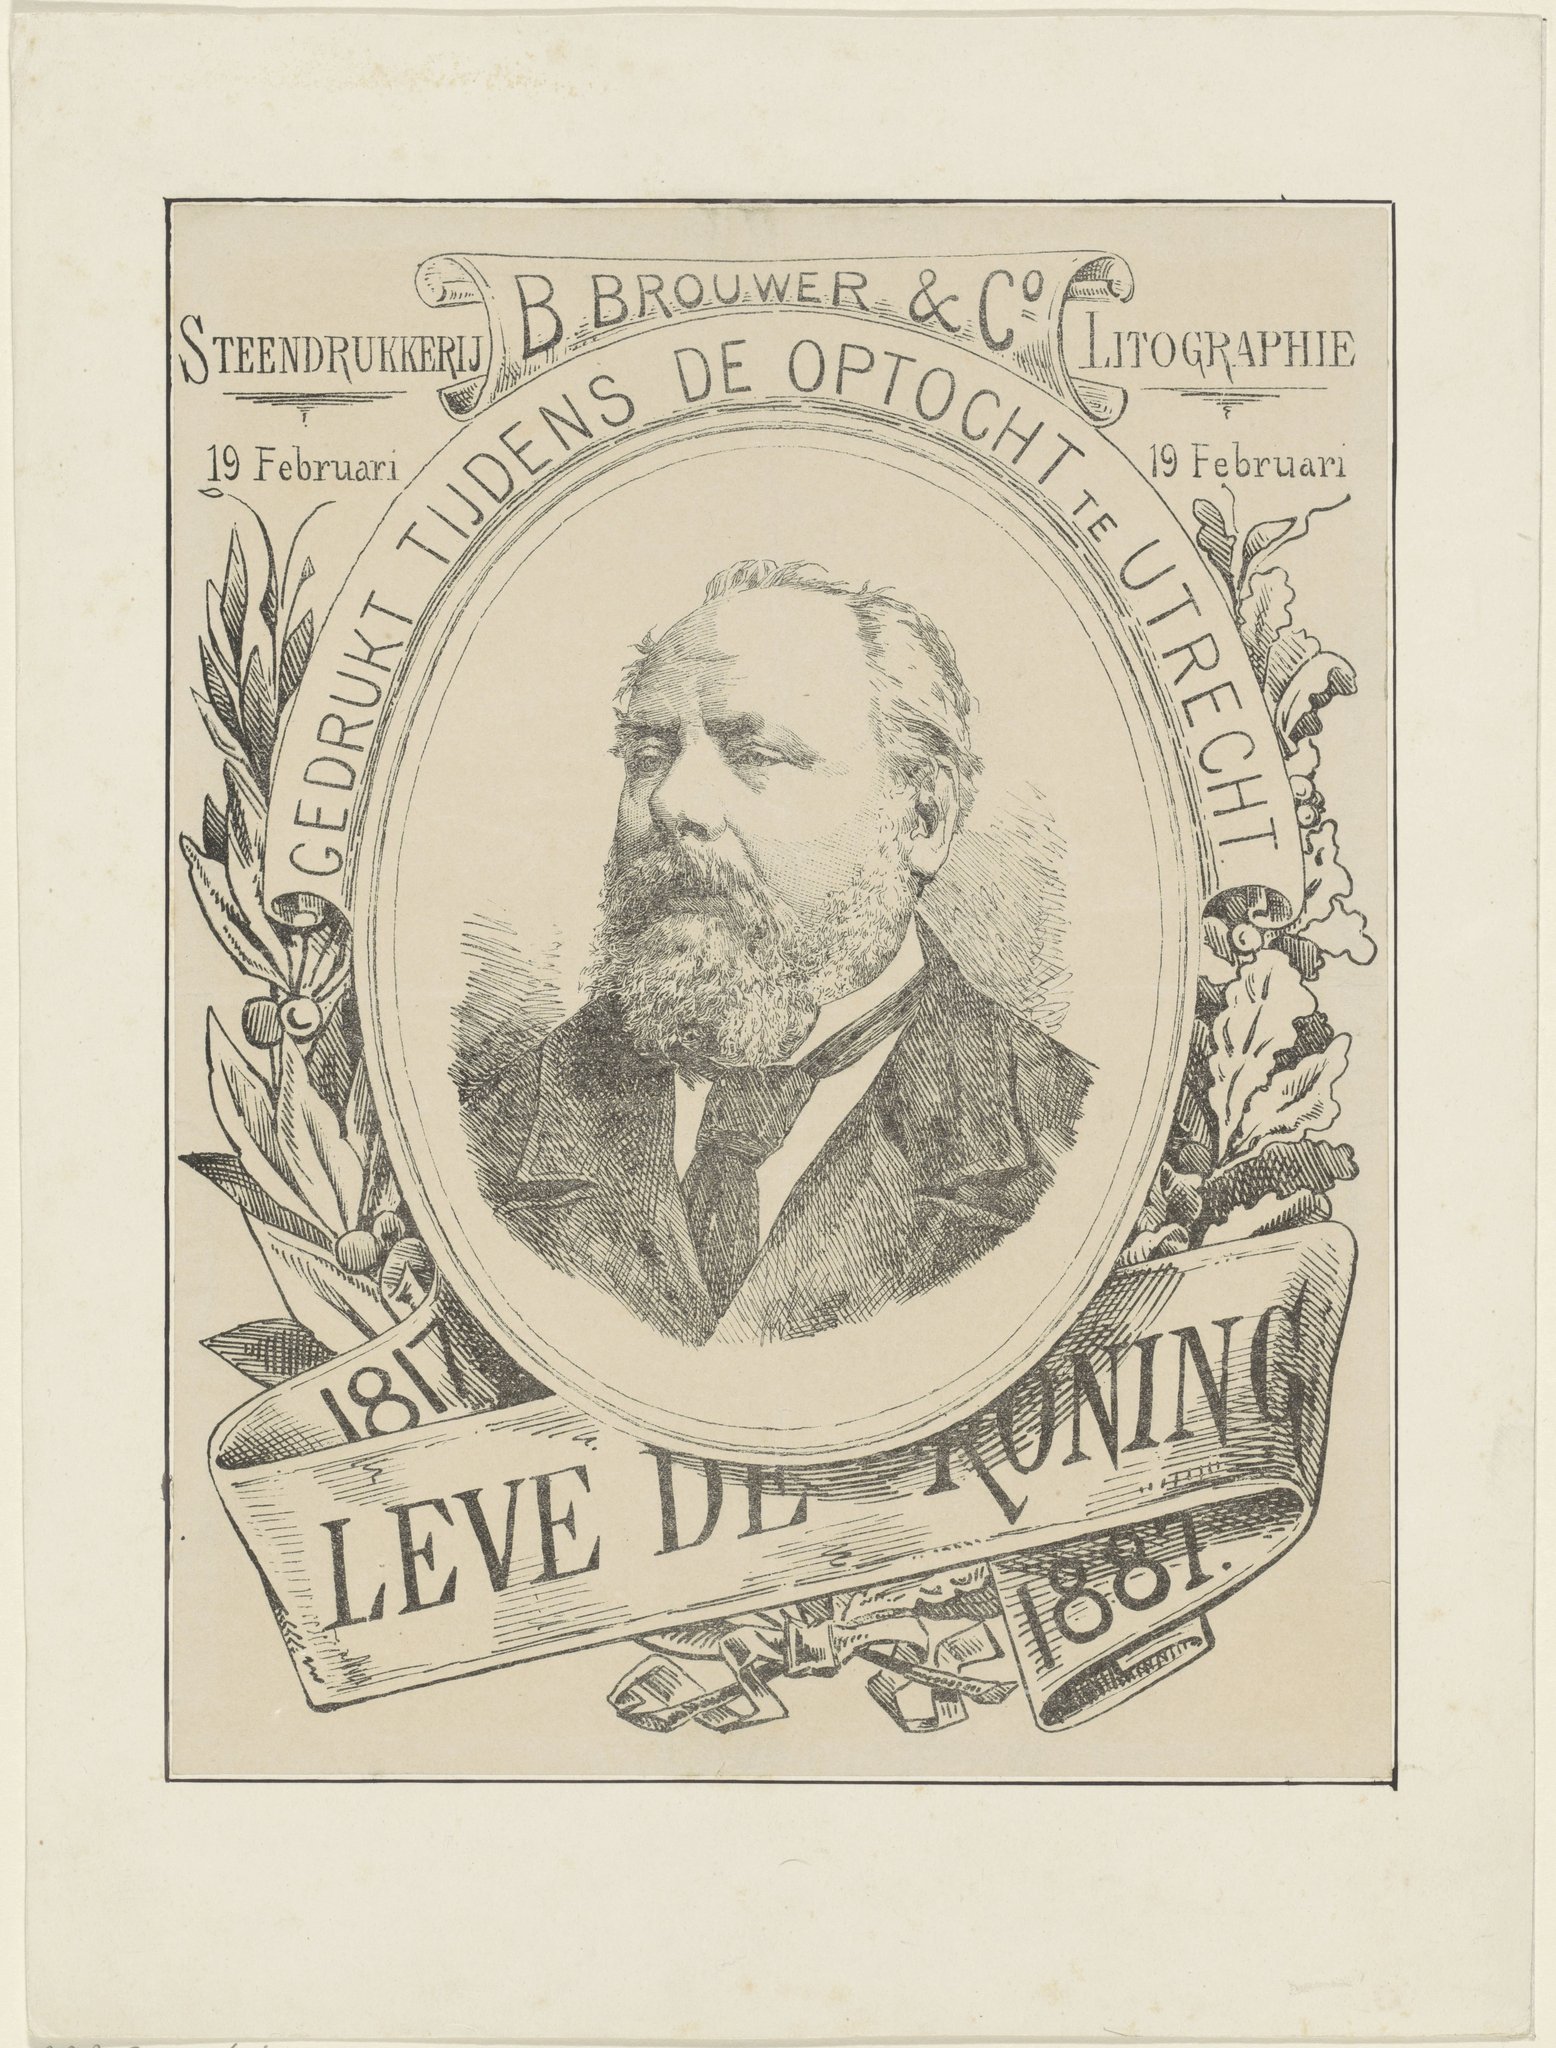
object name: print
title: Portret van Willem III, koning der Nederlanden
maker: Anonymous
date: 1887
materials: paper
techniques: lithograph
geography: utrecht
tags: brussels, willem iii (koning der nederlanden), utrecht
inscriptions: date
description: Portret van Willem III in een ovaal met randschrift. Op een banderol '1817 LEVE DE KONING 1887.'. Vervaardigd ter gelegenheid van de viering van de zeventigste verjaardag van Willem III te Utrecht op 19 februari 1887.